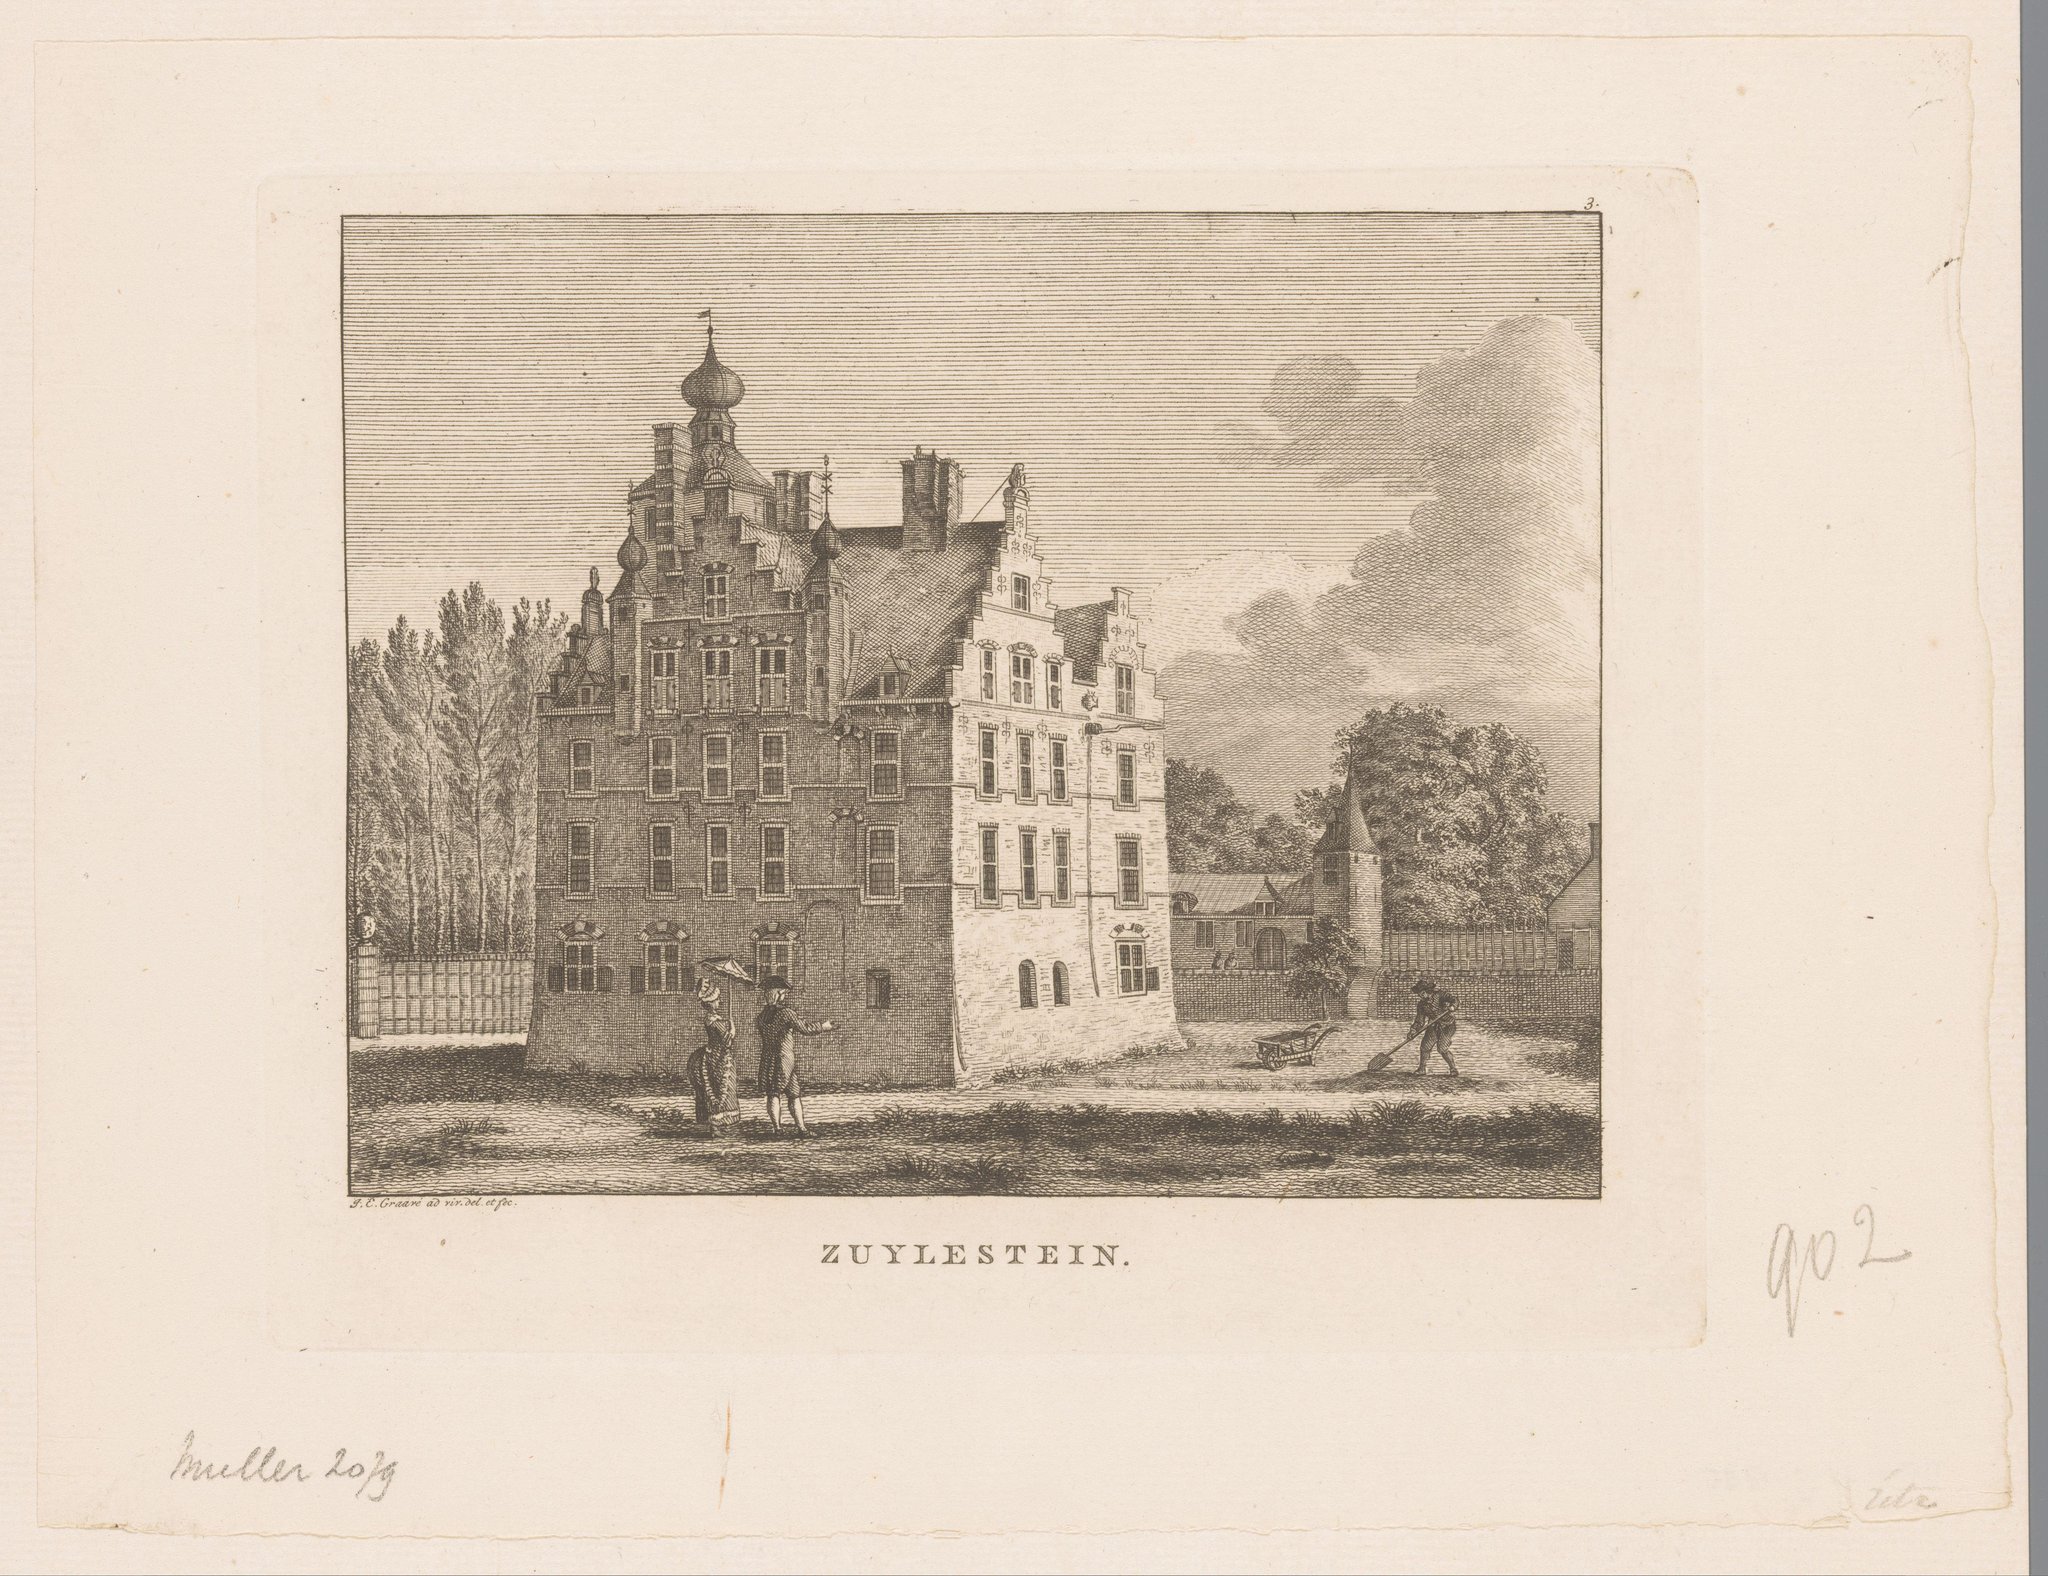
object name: print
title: Nederlandse dorpen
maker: jan evert grave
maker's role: draughtsman, print maker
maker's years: 1759-1805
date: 1786-1805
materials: paper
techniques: etching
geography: amsterdam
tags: castle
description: Het landgoed Zuylestein. Op de voorgrond een paar. De prent maakt deel uit van een serie met Nederlandse dorpen.